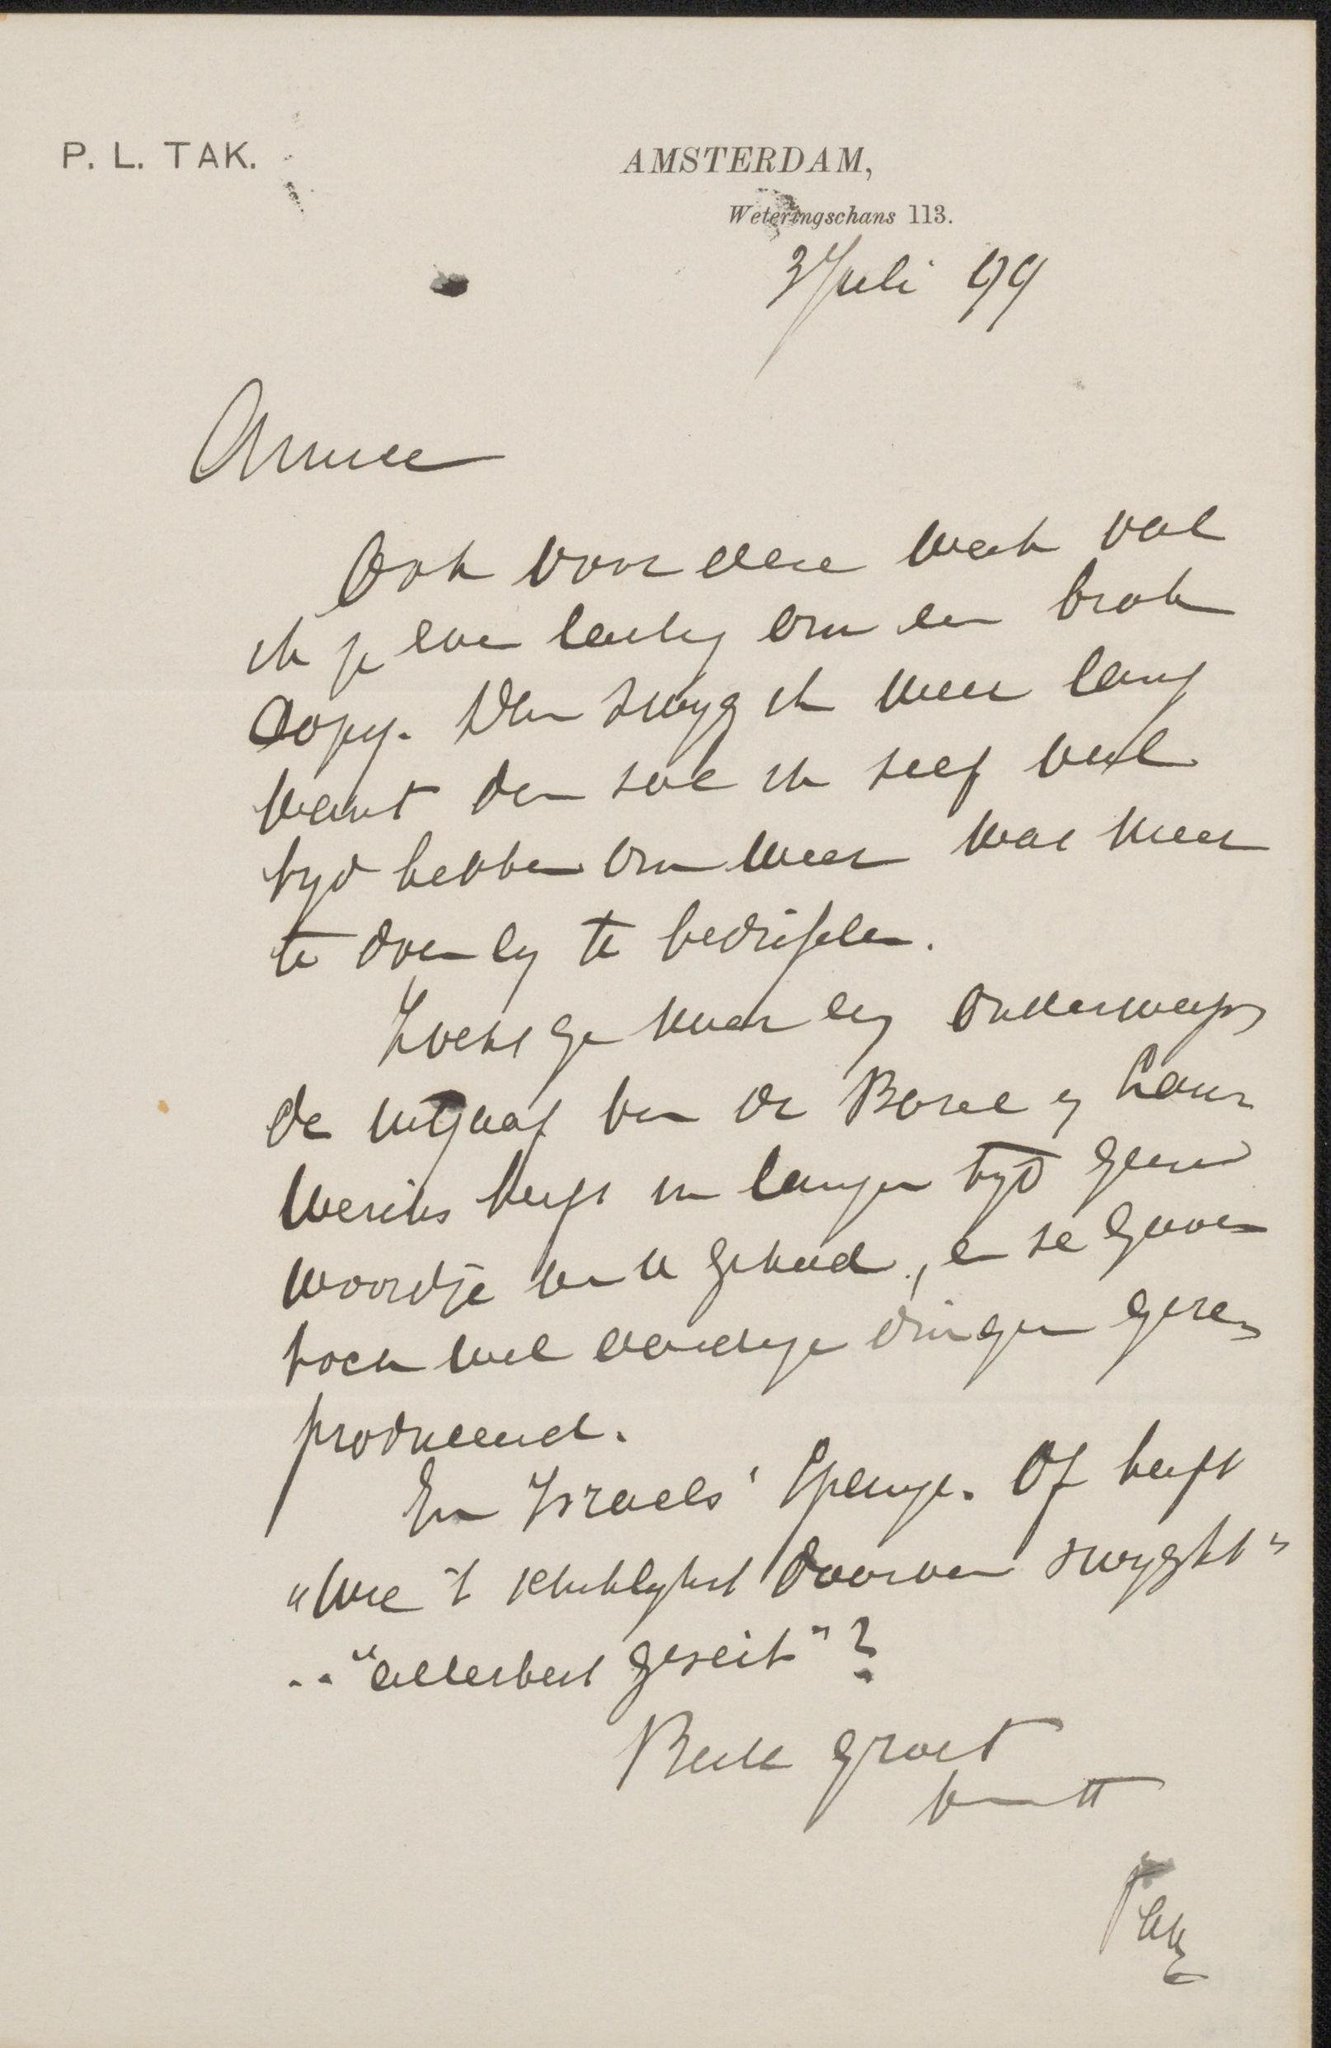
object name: letter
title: Brief aan Jan Veth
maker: pieter lodewijk tak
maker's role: politician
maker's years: 1848-1907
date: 1899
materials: ink, paper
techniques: pen, printing, writing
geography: amsterdam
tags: painter, jan veth, den helder, karel petrus cornelis de bazel, amsterdam, print maker, draughtsman, designer, mathieu lauweriks, printed matter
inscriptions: collector's mark: ‘RPK’, watermark